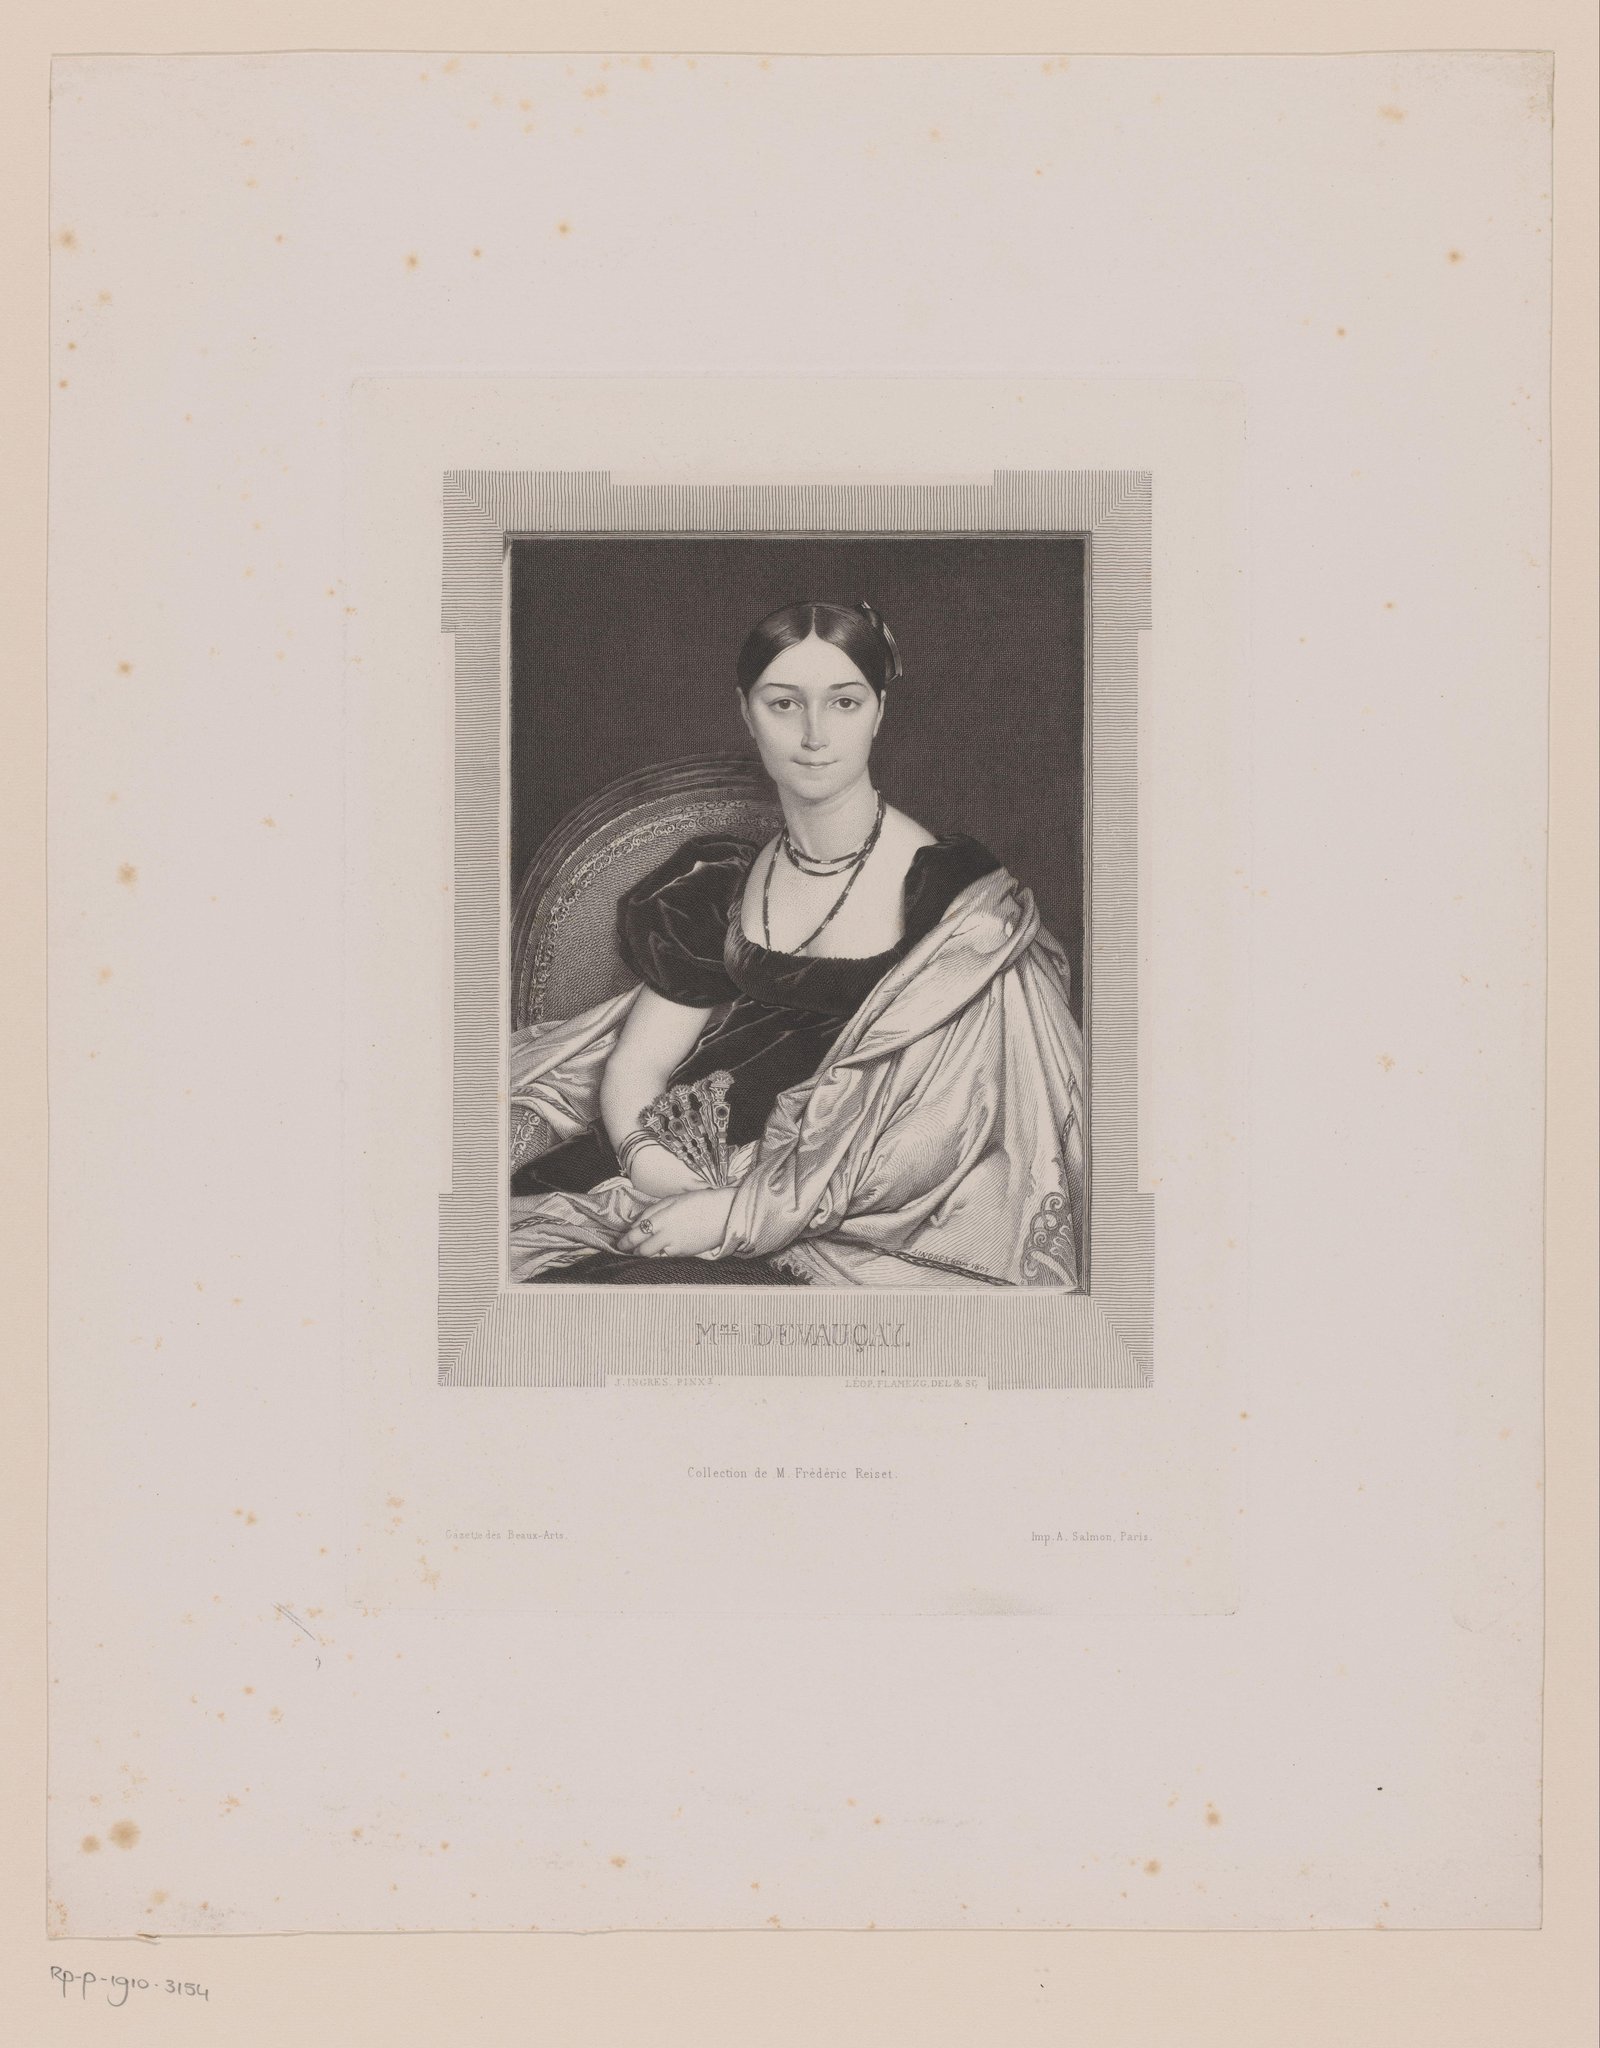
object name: print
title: Portret van Antonia Duvauçey de Nittis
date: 1867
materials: paper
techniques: engraving, etching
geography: paris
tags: historical persons - bb - woman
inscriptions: collector's mark: Lugt 2228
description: Prent uit: Gazette des beaux-arts (1867), dl. 2, p. 58.